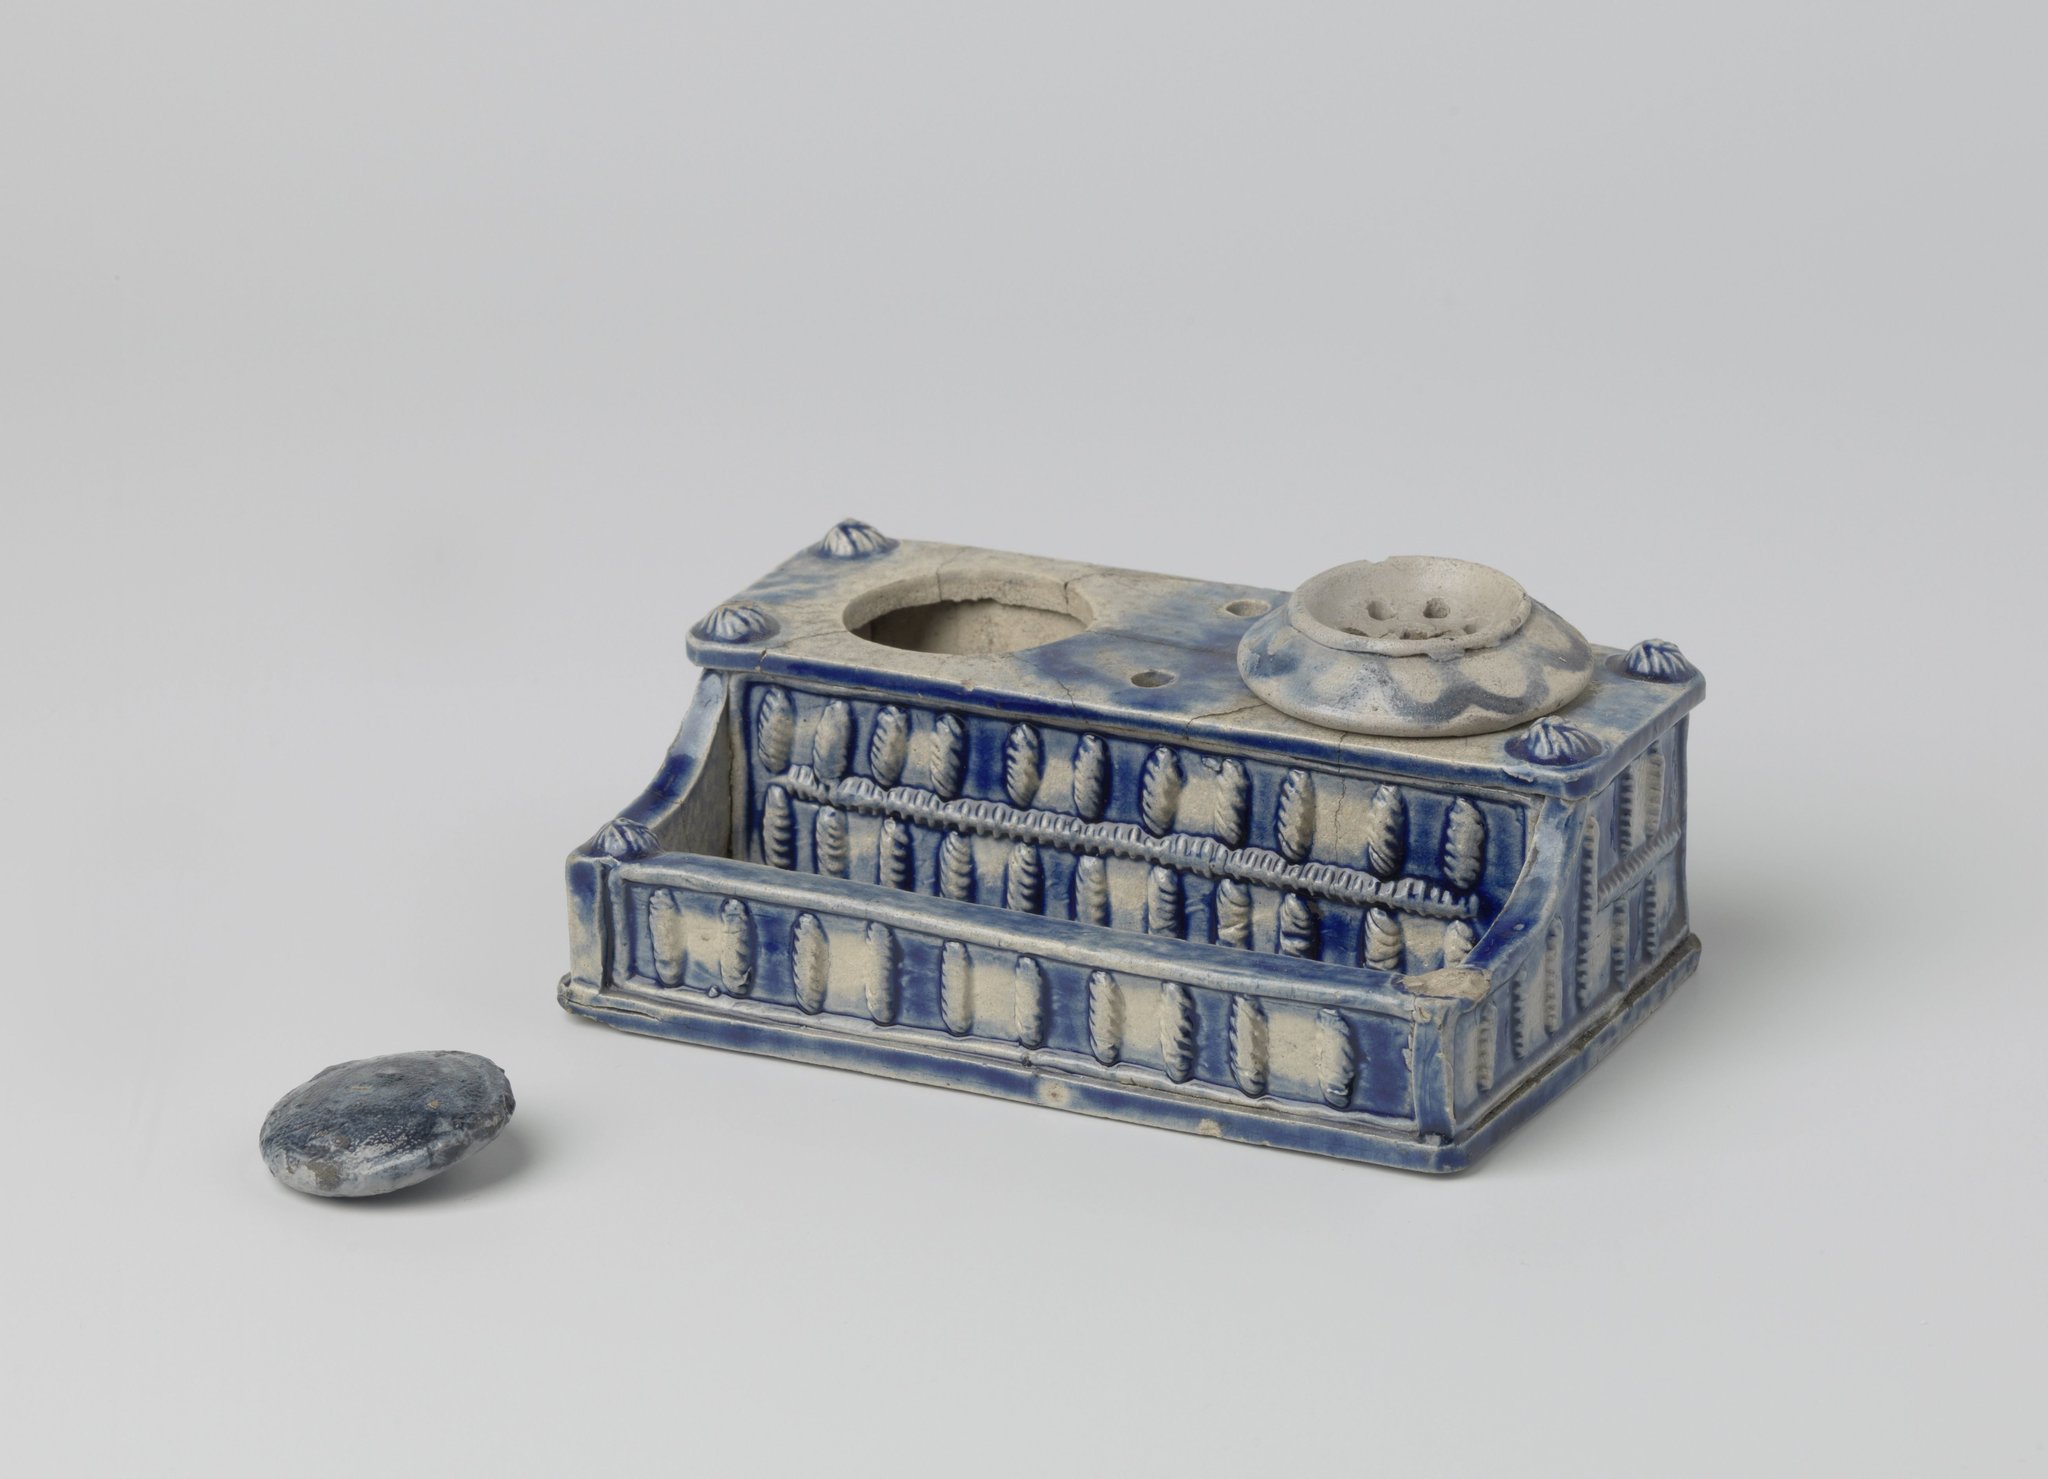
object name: inkstand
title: Ink stand with a relief decoration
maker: Anonymous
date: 1750-1799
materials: cobalt, glaze, stoneware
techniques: embroidery, firing, forming, relief, turning, vitrification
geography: westerwald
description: Inkstel van steengoed met een pennenbak en twee houders voor de inktpot en de zandstrooier. Gedeeltelijk bedekt met kobaltblauw. Het stel is versierd met een gedrukte en opgelegde reliëfdecoratie. Op elke hoek aan de bovenzijde een gemodelleerde 'klinknagel'. De cilincrische zandstrooier is opengewerkt aan de bovenzijde. De inktpot ontbreekt, alleen de deksel is aanwezig. Westerwald.